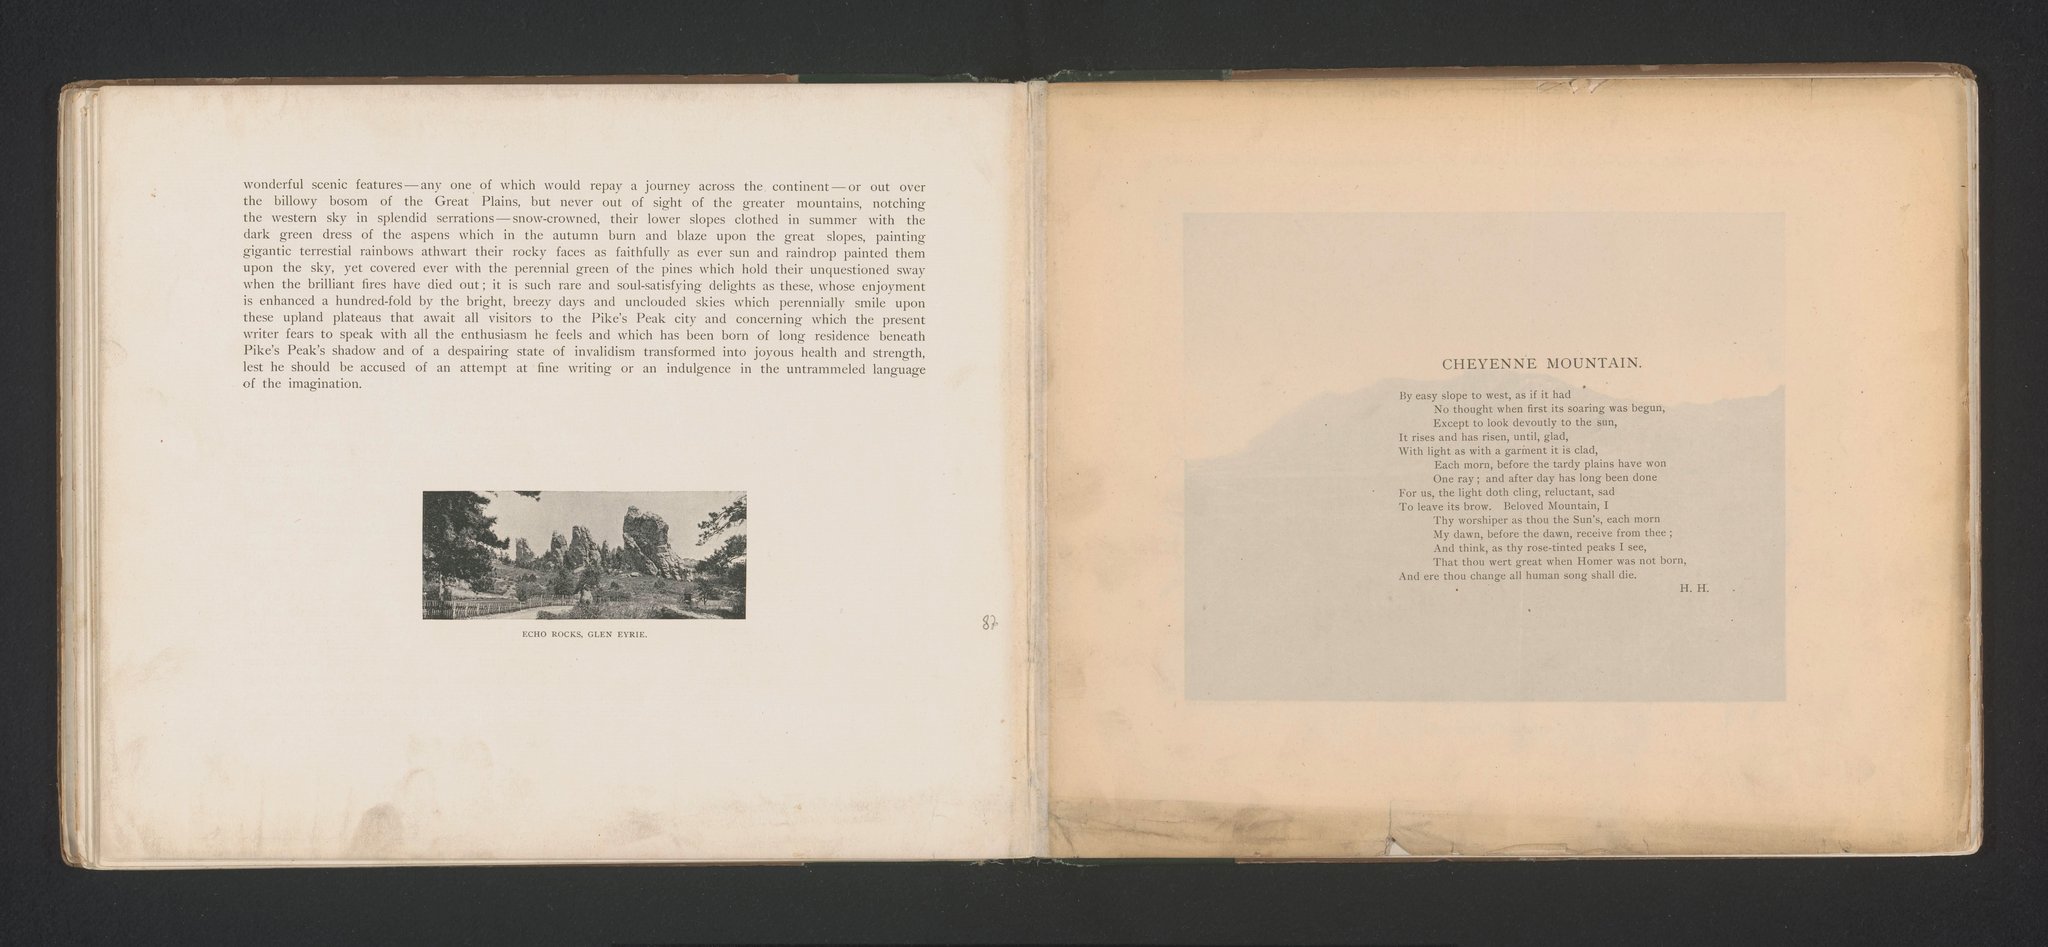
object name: page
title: Echo Rocks, Glen Eyrie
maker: Anonymous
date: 1888-1893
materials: paper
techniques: autotype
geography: colorado springs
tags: rock-formations